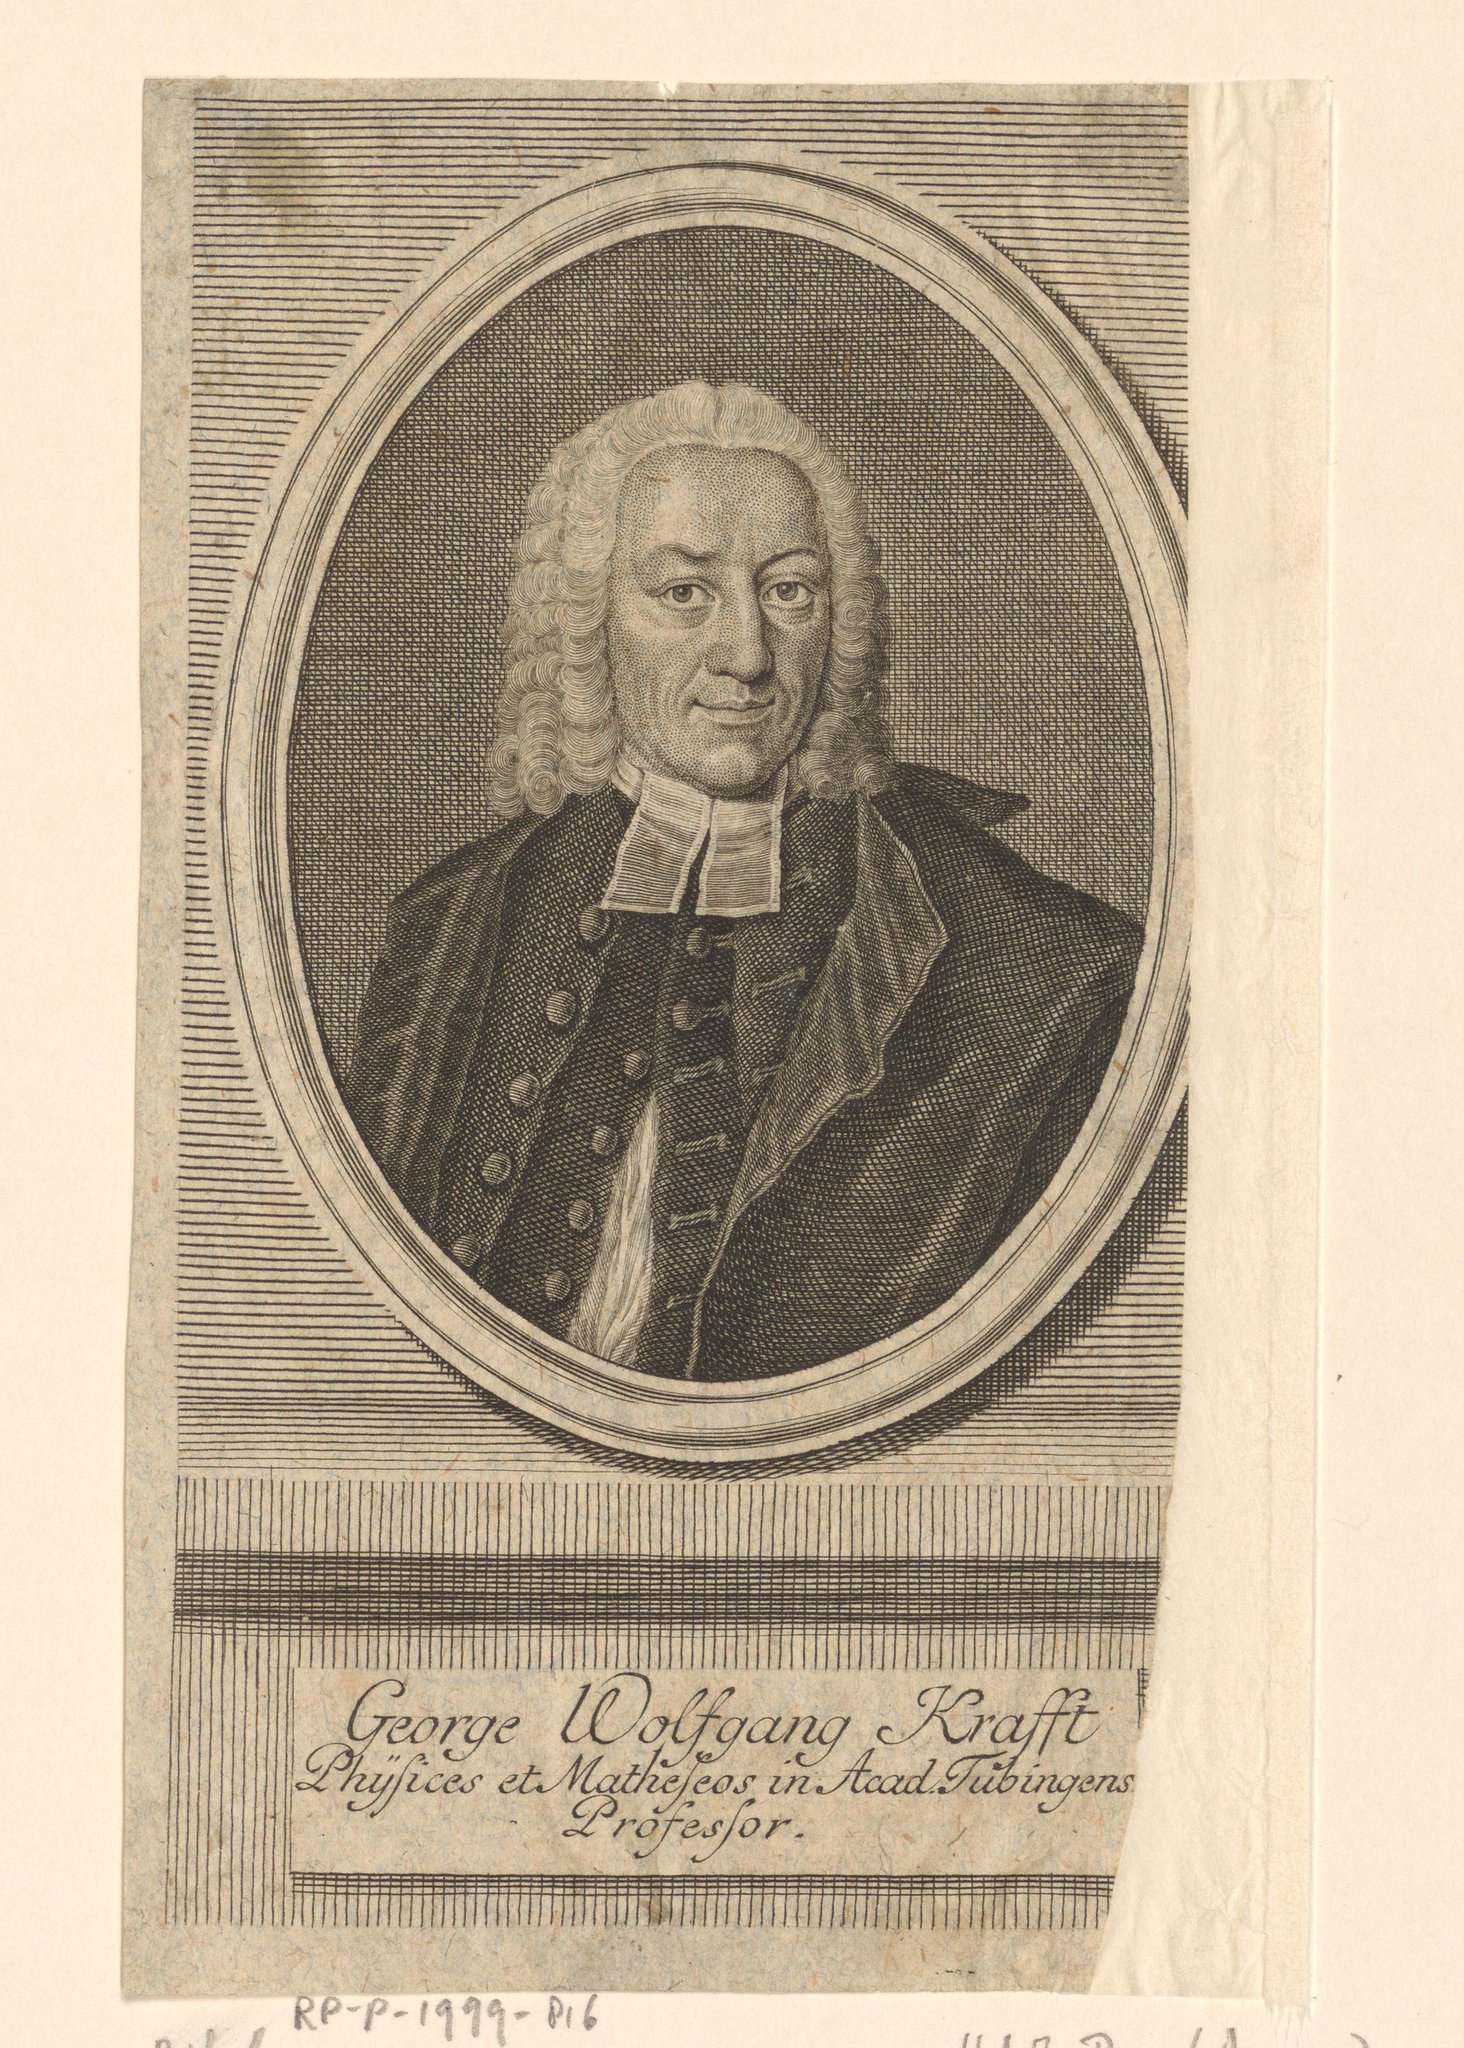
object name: print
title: Portret van Georg Wolfgang Krafft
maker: Anonymous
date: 1731-1799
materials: paper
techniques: engraving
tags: physicist, historical persons, mathematics (+ portrait of scholar, scientist)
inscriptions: collector's mark: Lugt 2228